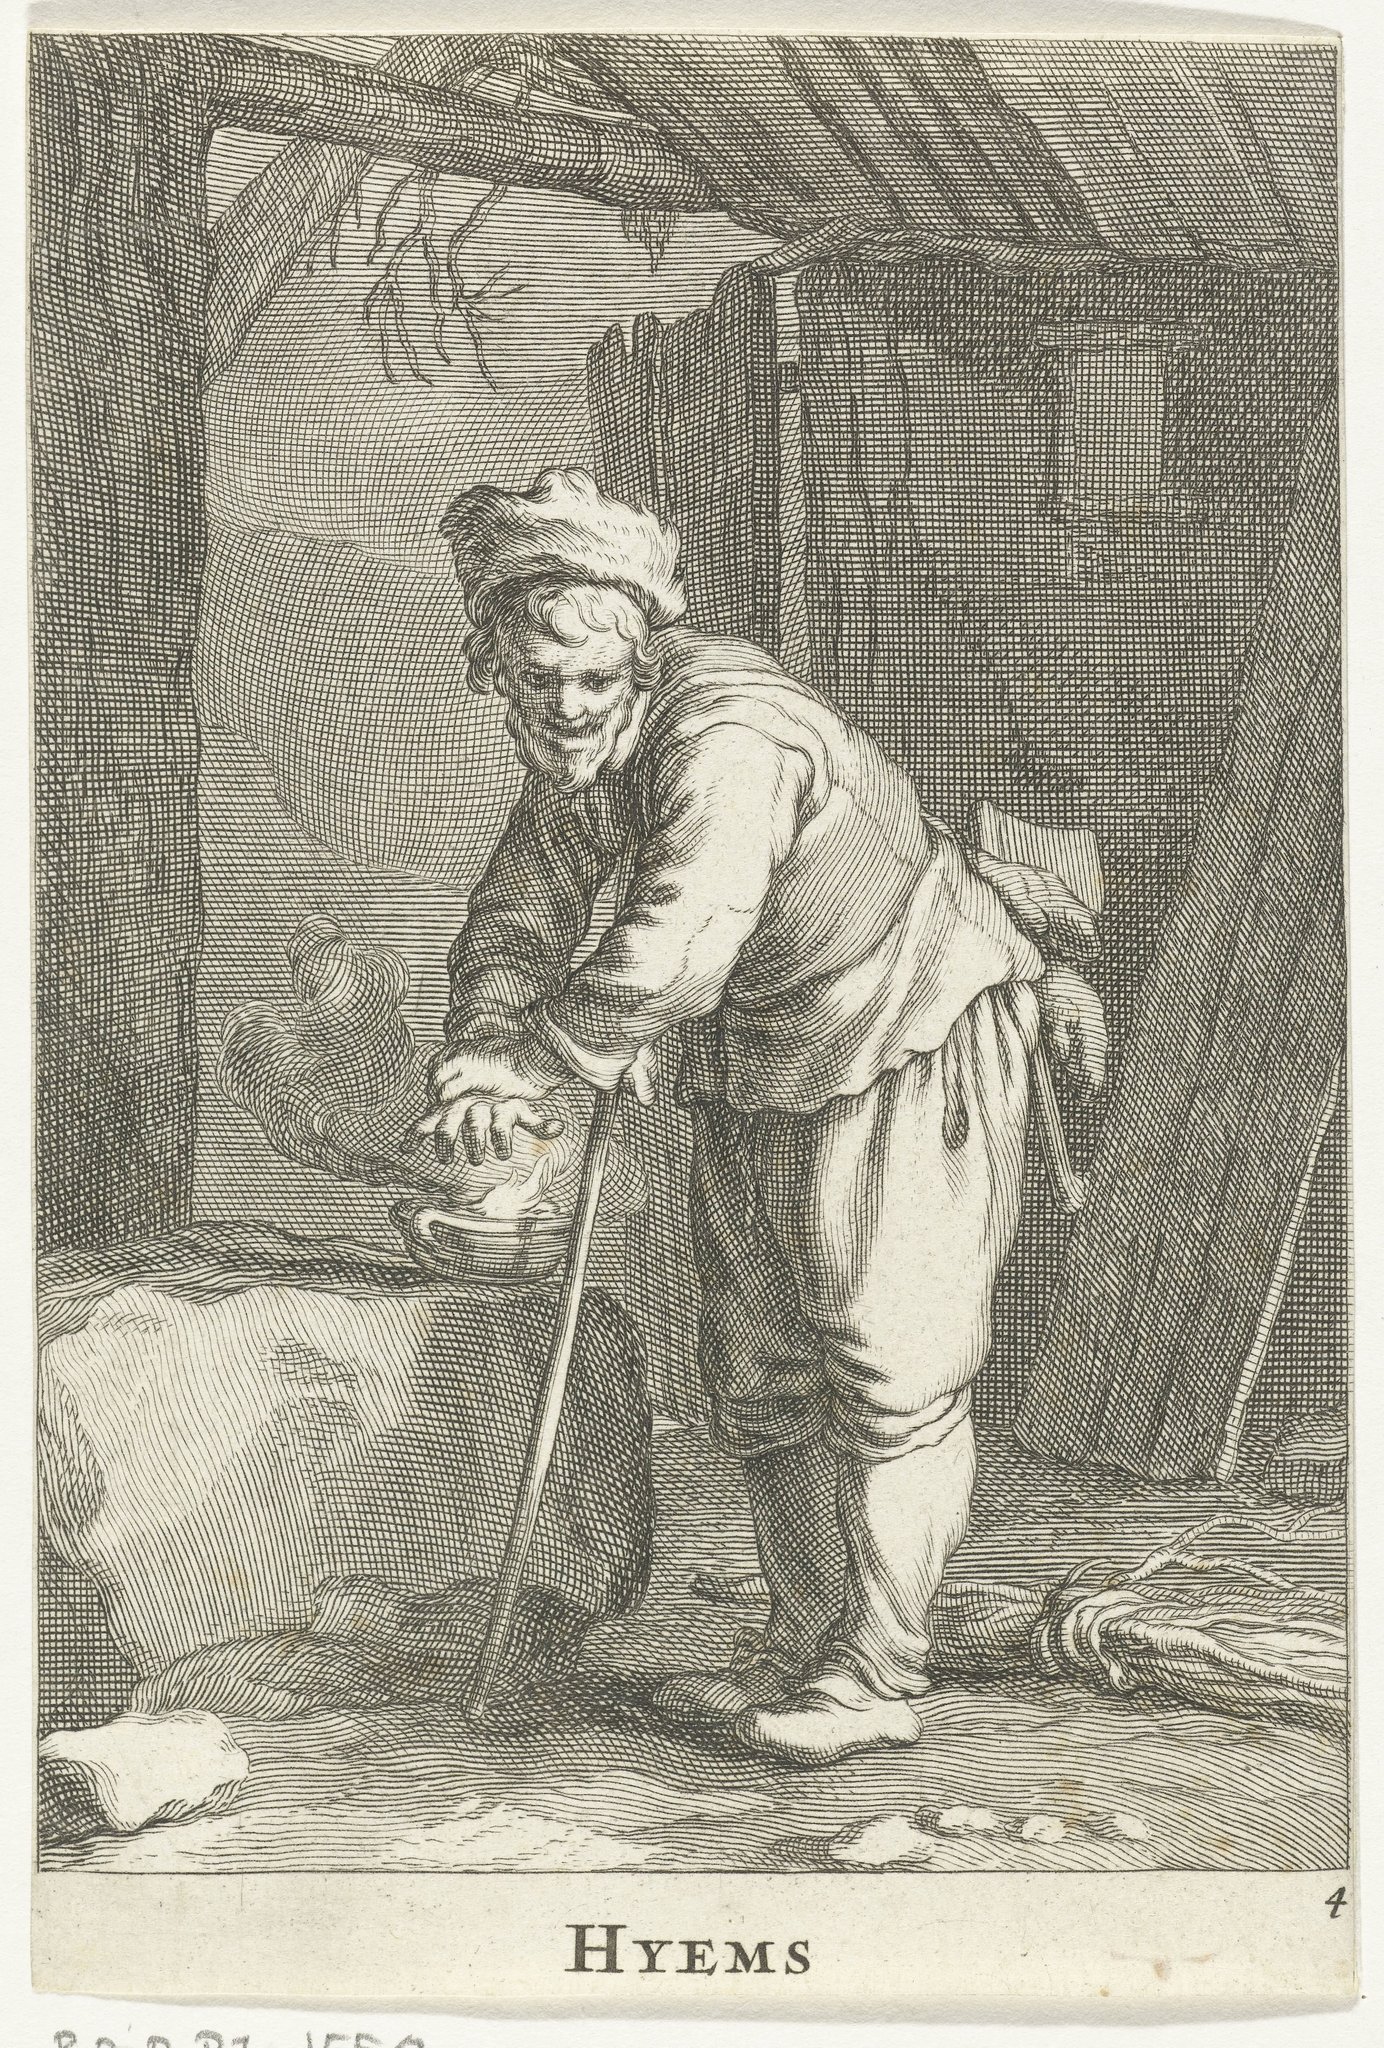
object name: print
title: Winter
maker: frederick bloemaert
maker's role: print maker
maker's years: 1614-1669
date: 1632-1670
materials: paper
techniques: engraving, etching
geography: utrecht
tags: warming oneself at a fire (or hearth, stove, fire-pan, brazier), winter ~ human activities (the four seasons of the year)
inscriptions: collector's mark: Lugt 240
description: Een oude man staat in een schuur en warmt zijn handen aan een vuur. Zijn linkerarm steunt op een stok. Op de grond ligt een takkenbos.